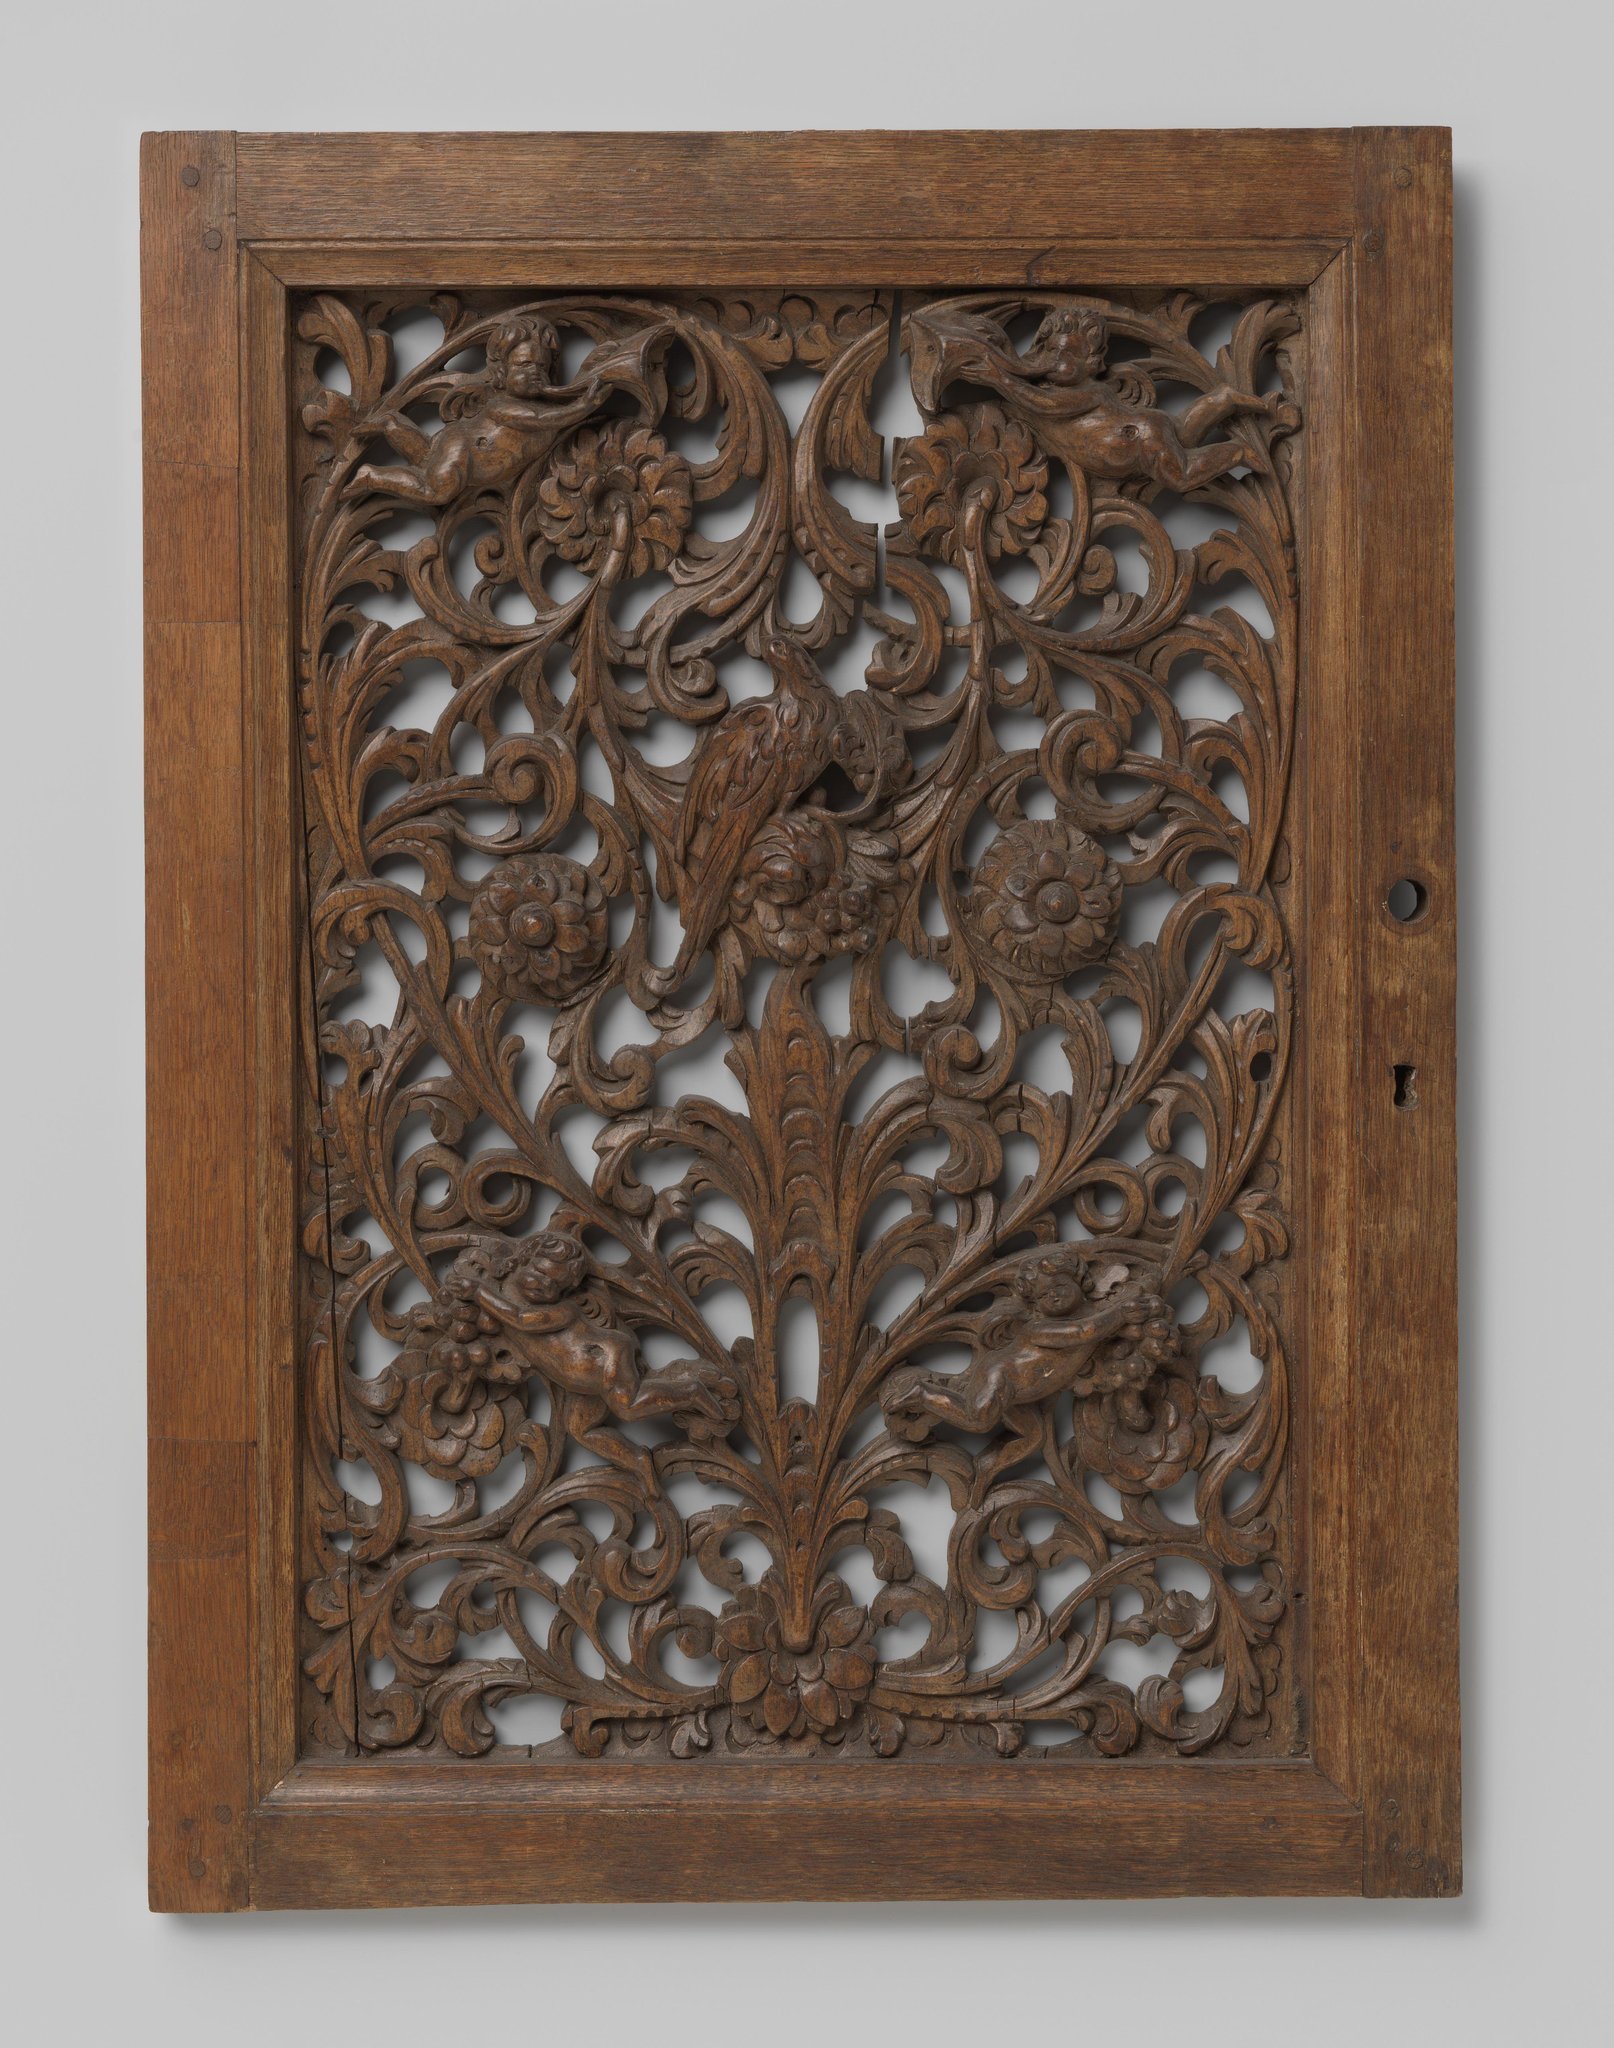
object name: furniture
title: Paneel met opengewerkt symmetrisch ornament van acanthusranken met bloemen en putti en in het midden een adelaar op bloem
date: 1650-1699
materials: wood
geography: enkhuizen